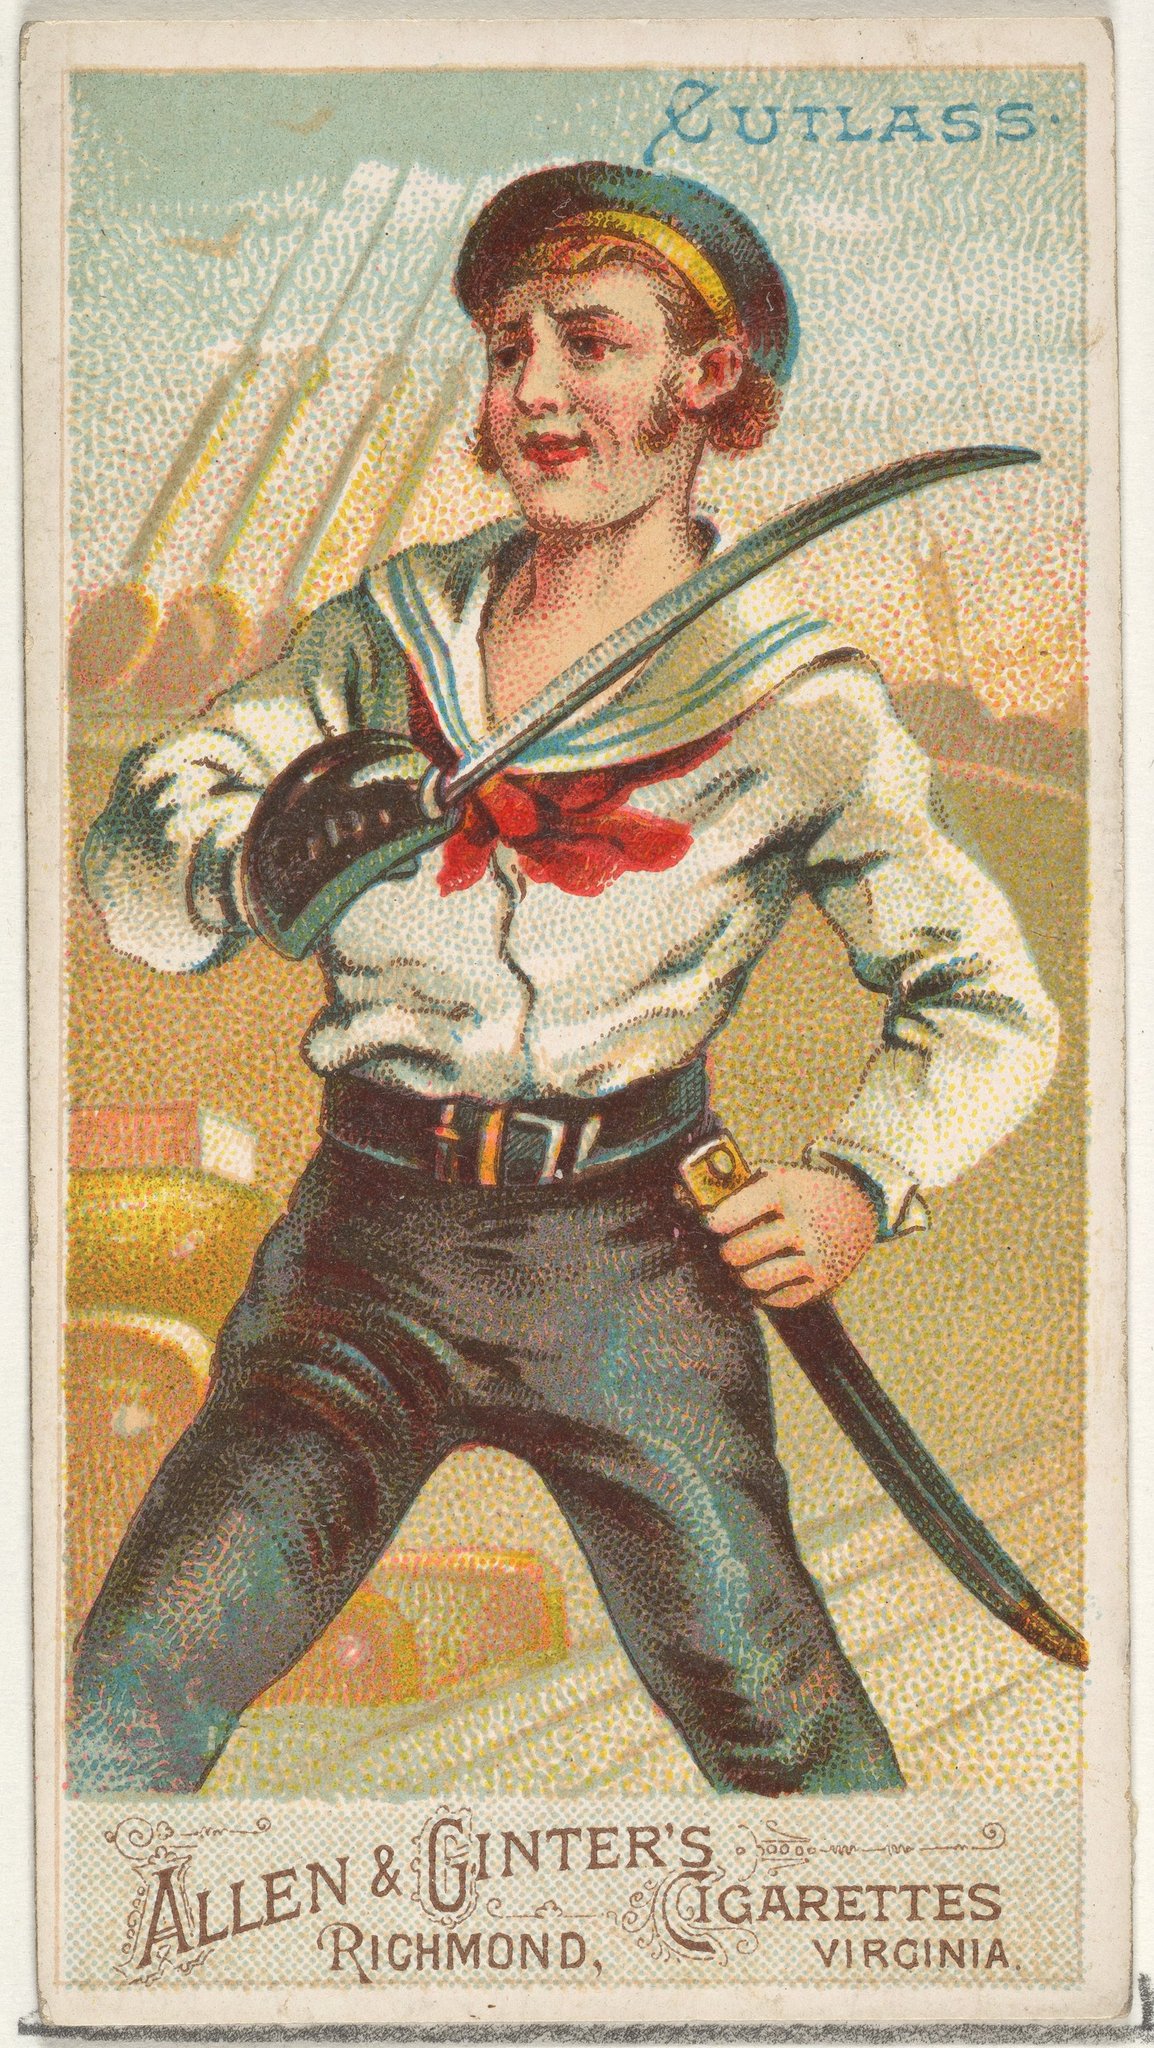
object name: print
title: Cutlass, from the Arms of All Nations series (N3) for Allen & Ginter Cigarettes Brands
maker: allen & ginter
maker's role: publisher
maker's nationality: american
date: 1887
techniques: color lithograph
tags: swords,men